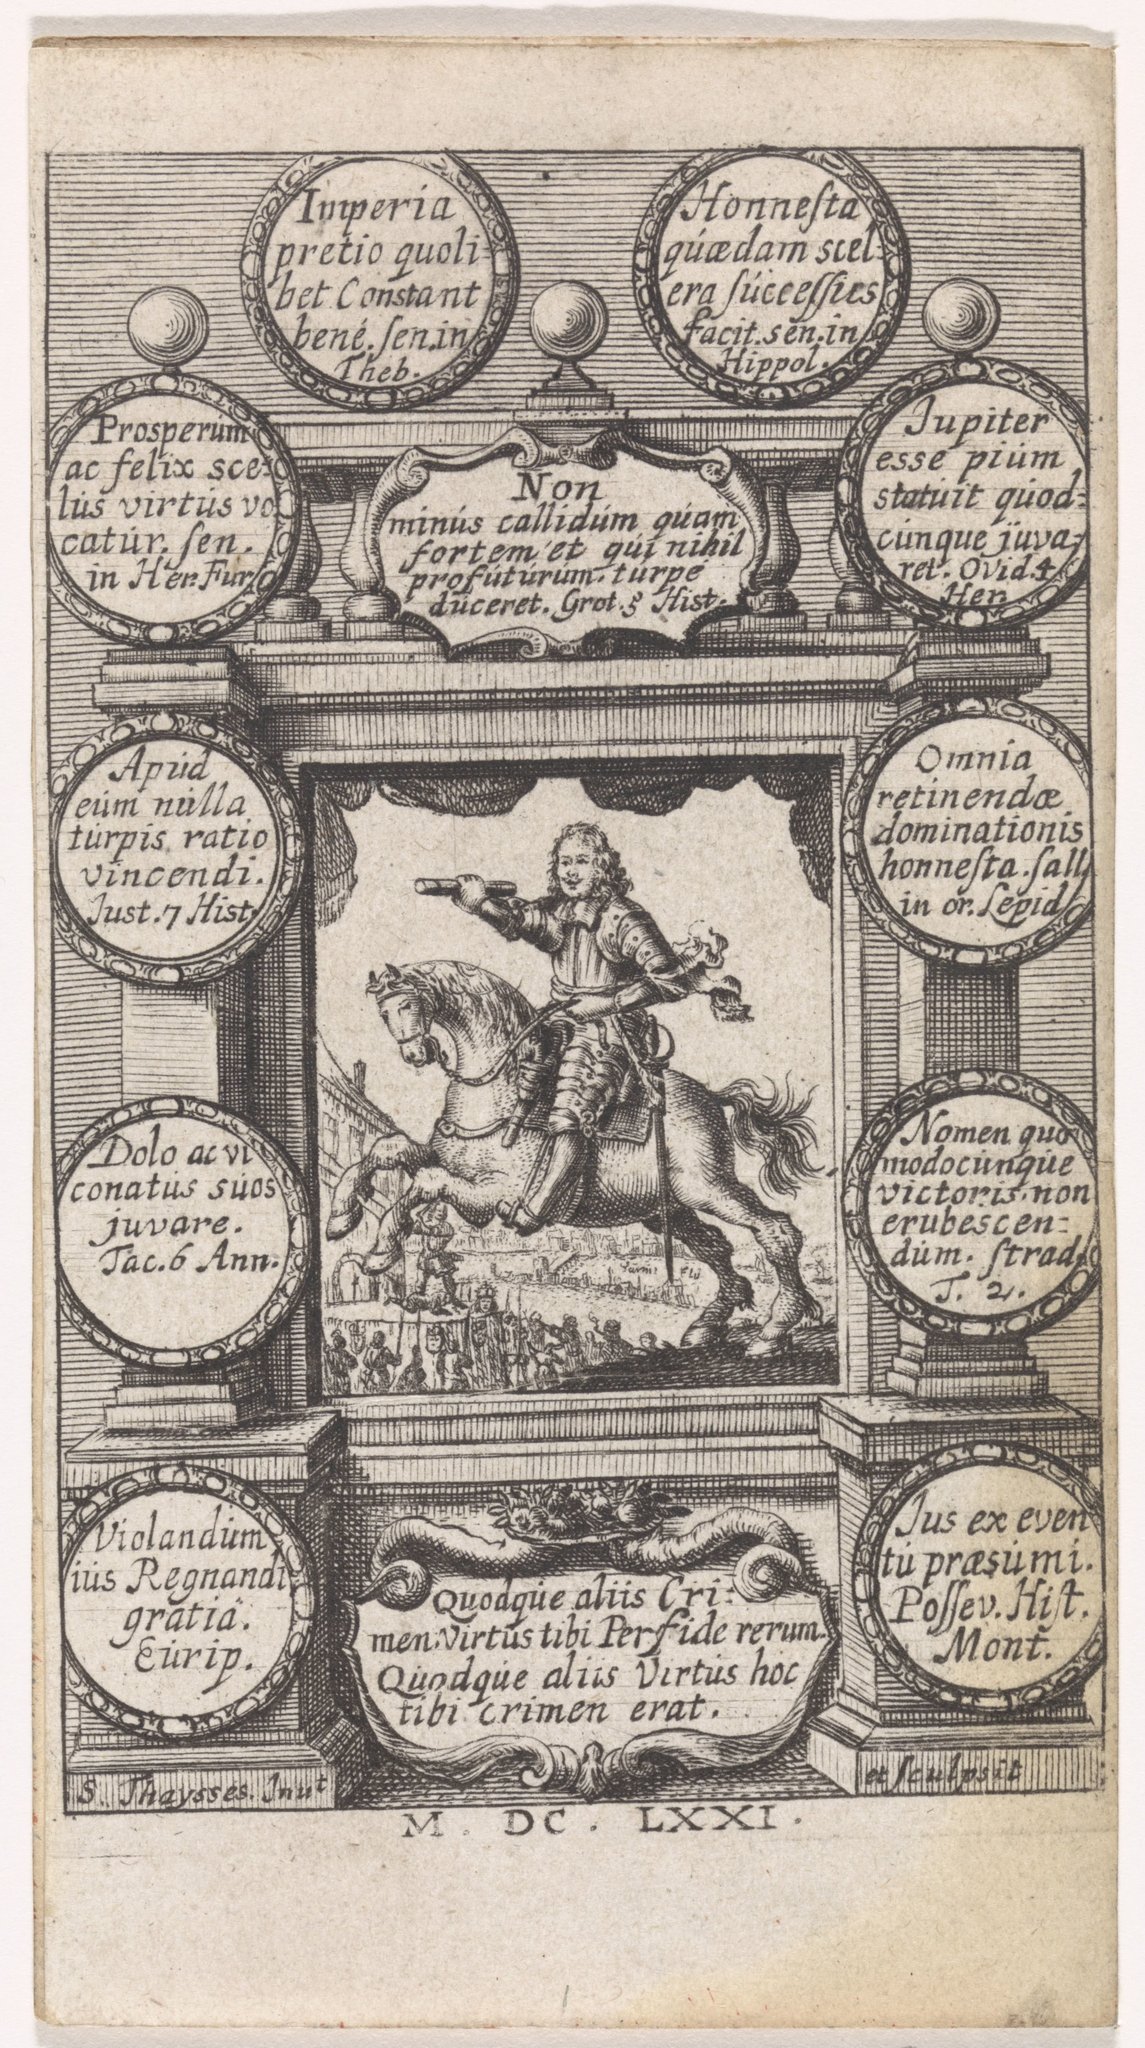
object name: print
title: Titelpagina voor: Ferdinand de Galardi, a tyrannie heureuse ou Cromwel politique, 1671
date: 1671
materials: paper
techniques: engraving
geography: leiden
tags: london, karel i (koning van engeland), oliver cromwell, riding a horse, ass, or mule; rider, horseman, violent death by beheading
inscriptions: collector's mark: Lugt 2228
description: Oliver Cromwell als bevelhebber te paard met op de achtergrond de onthoofding van Karel I van Engeland. De voorstelling is gevat in een kader met boven en onder cartouches met teksten in het Latijn. Langs de zijkanten van het kader tien cirkels met daarbinnen teksten in het Latijn.